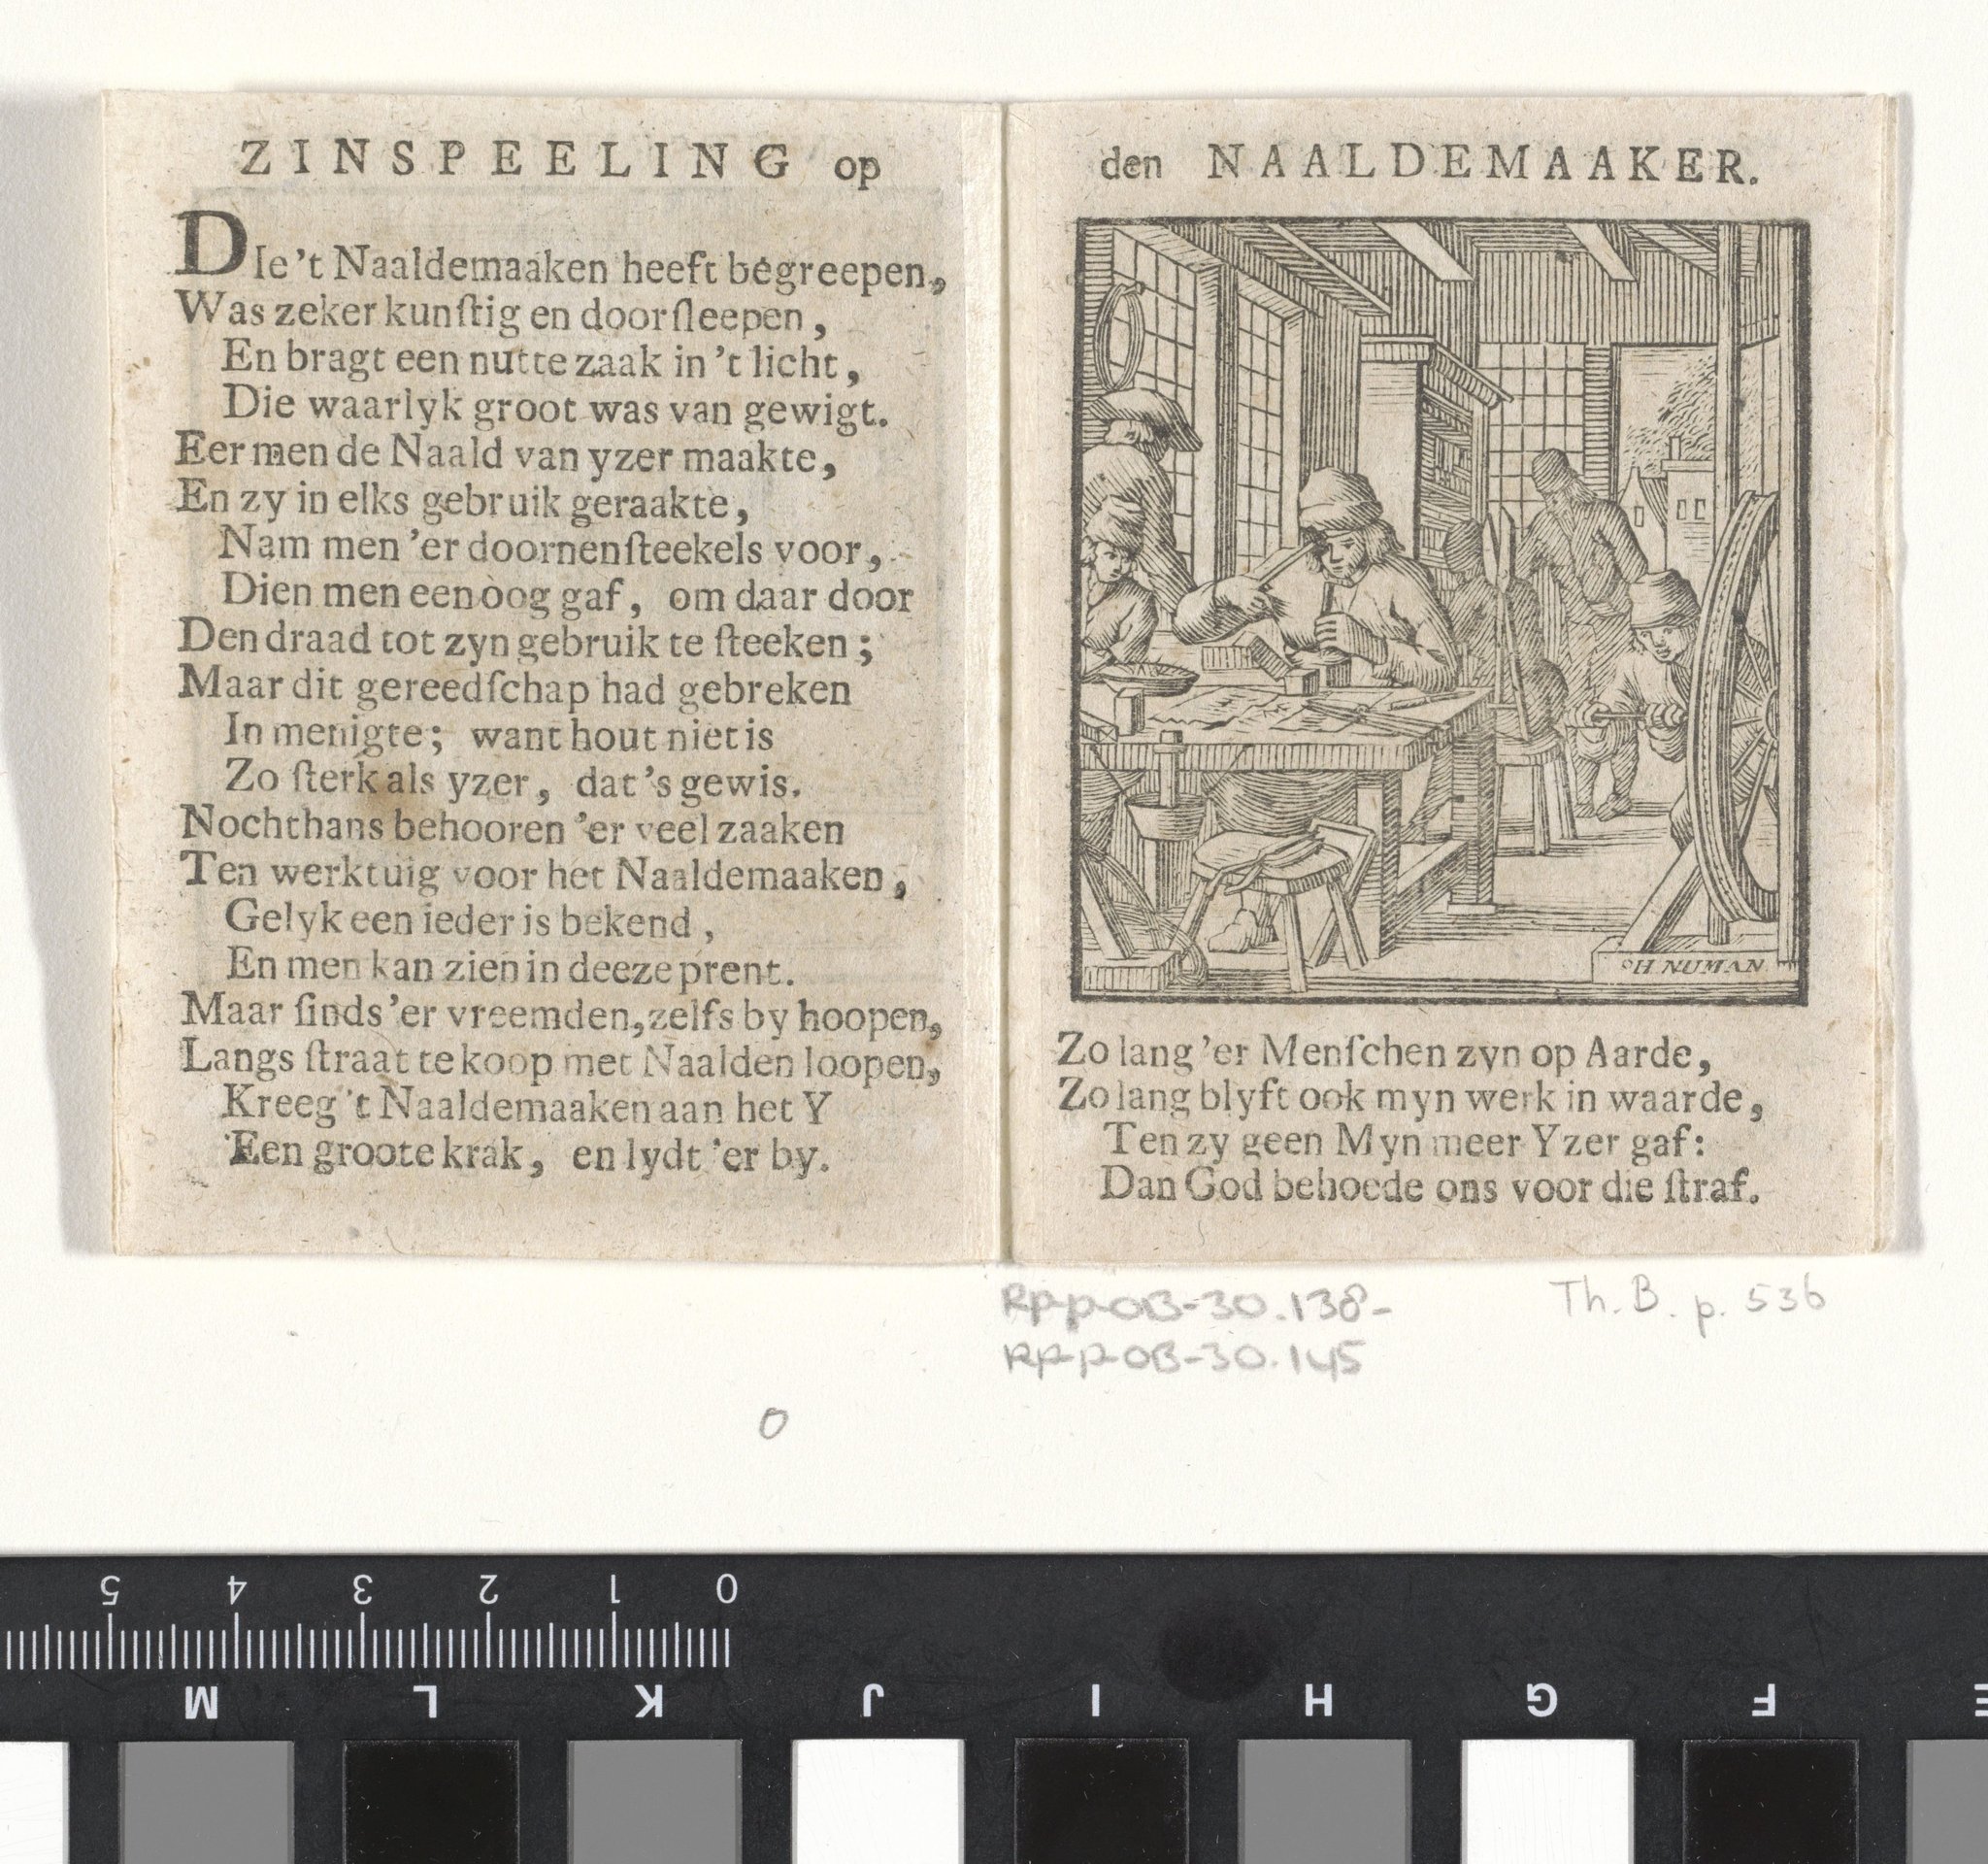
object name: book illustration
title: Zinspeeling op den naaldemaaker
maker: hendrik numan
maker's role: draughtsman, print maker, publisher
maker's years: 1736-1788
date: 1786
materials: paper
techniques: letterpress printing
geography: haarlem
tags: needle ~ sewing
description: Prent uit: Zinspeelingen op allerlei wetenschappen, konsten en ambachten: Continuation 17. Amsterdam: erven weduwe Cornelis Stichter, 1786.